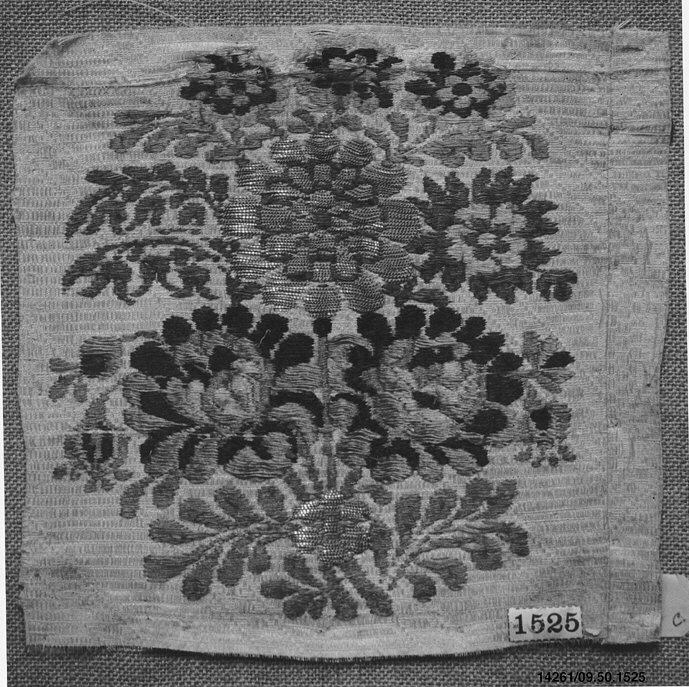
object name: piece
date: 1801-1900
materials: cotton, metal thread